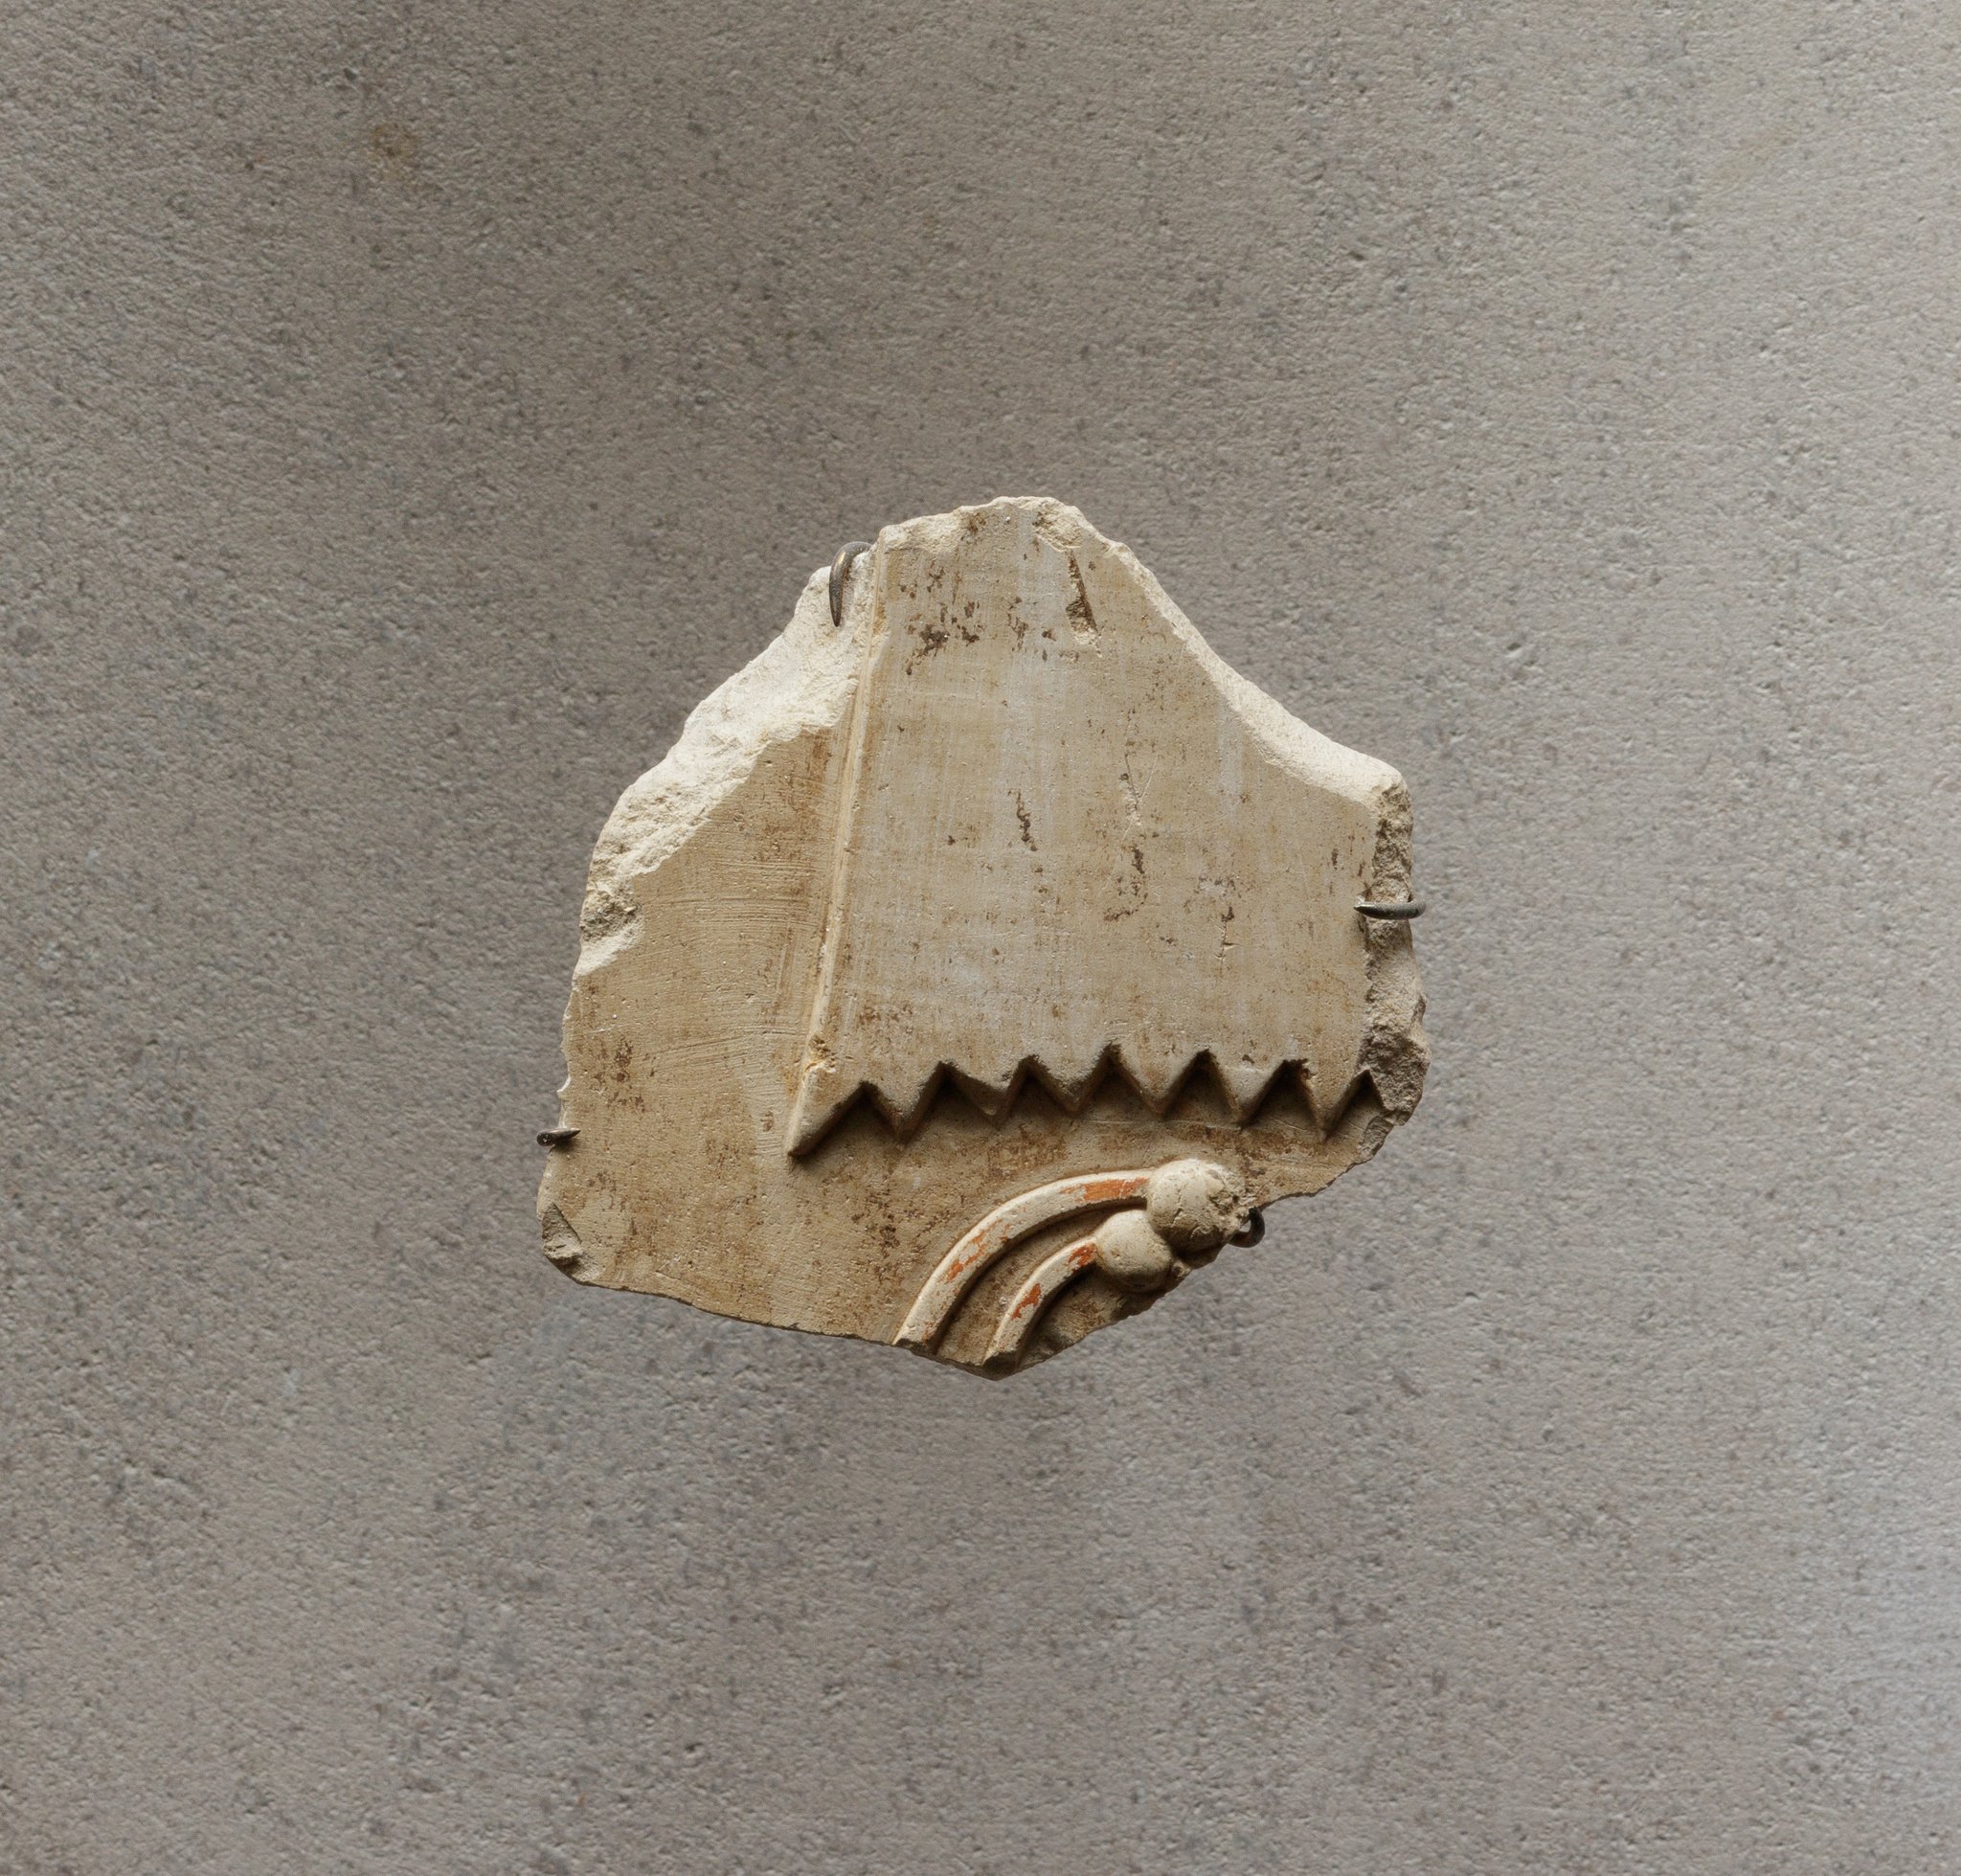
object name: relief, part of a sun shade and a necklace, neferu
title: Relief showing part of a sun shade and a necklace - see 26.3.353-3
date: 2051-2030 BCE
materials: limestone, paint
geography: egypt